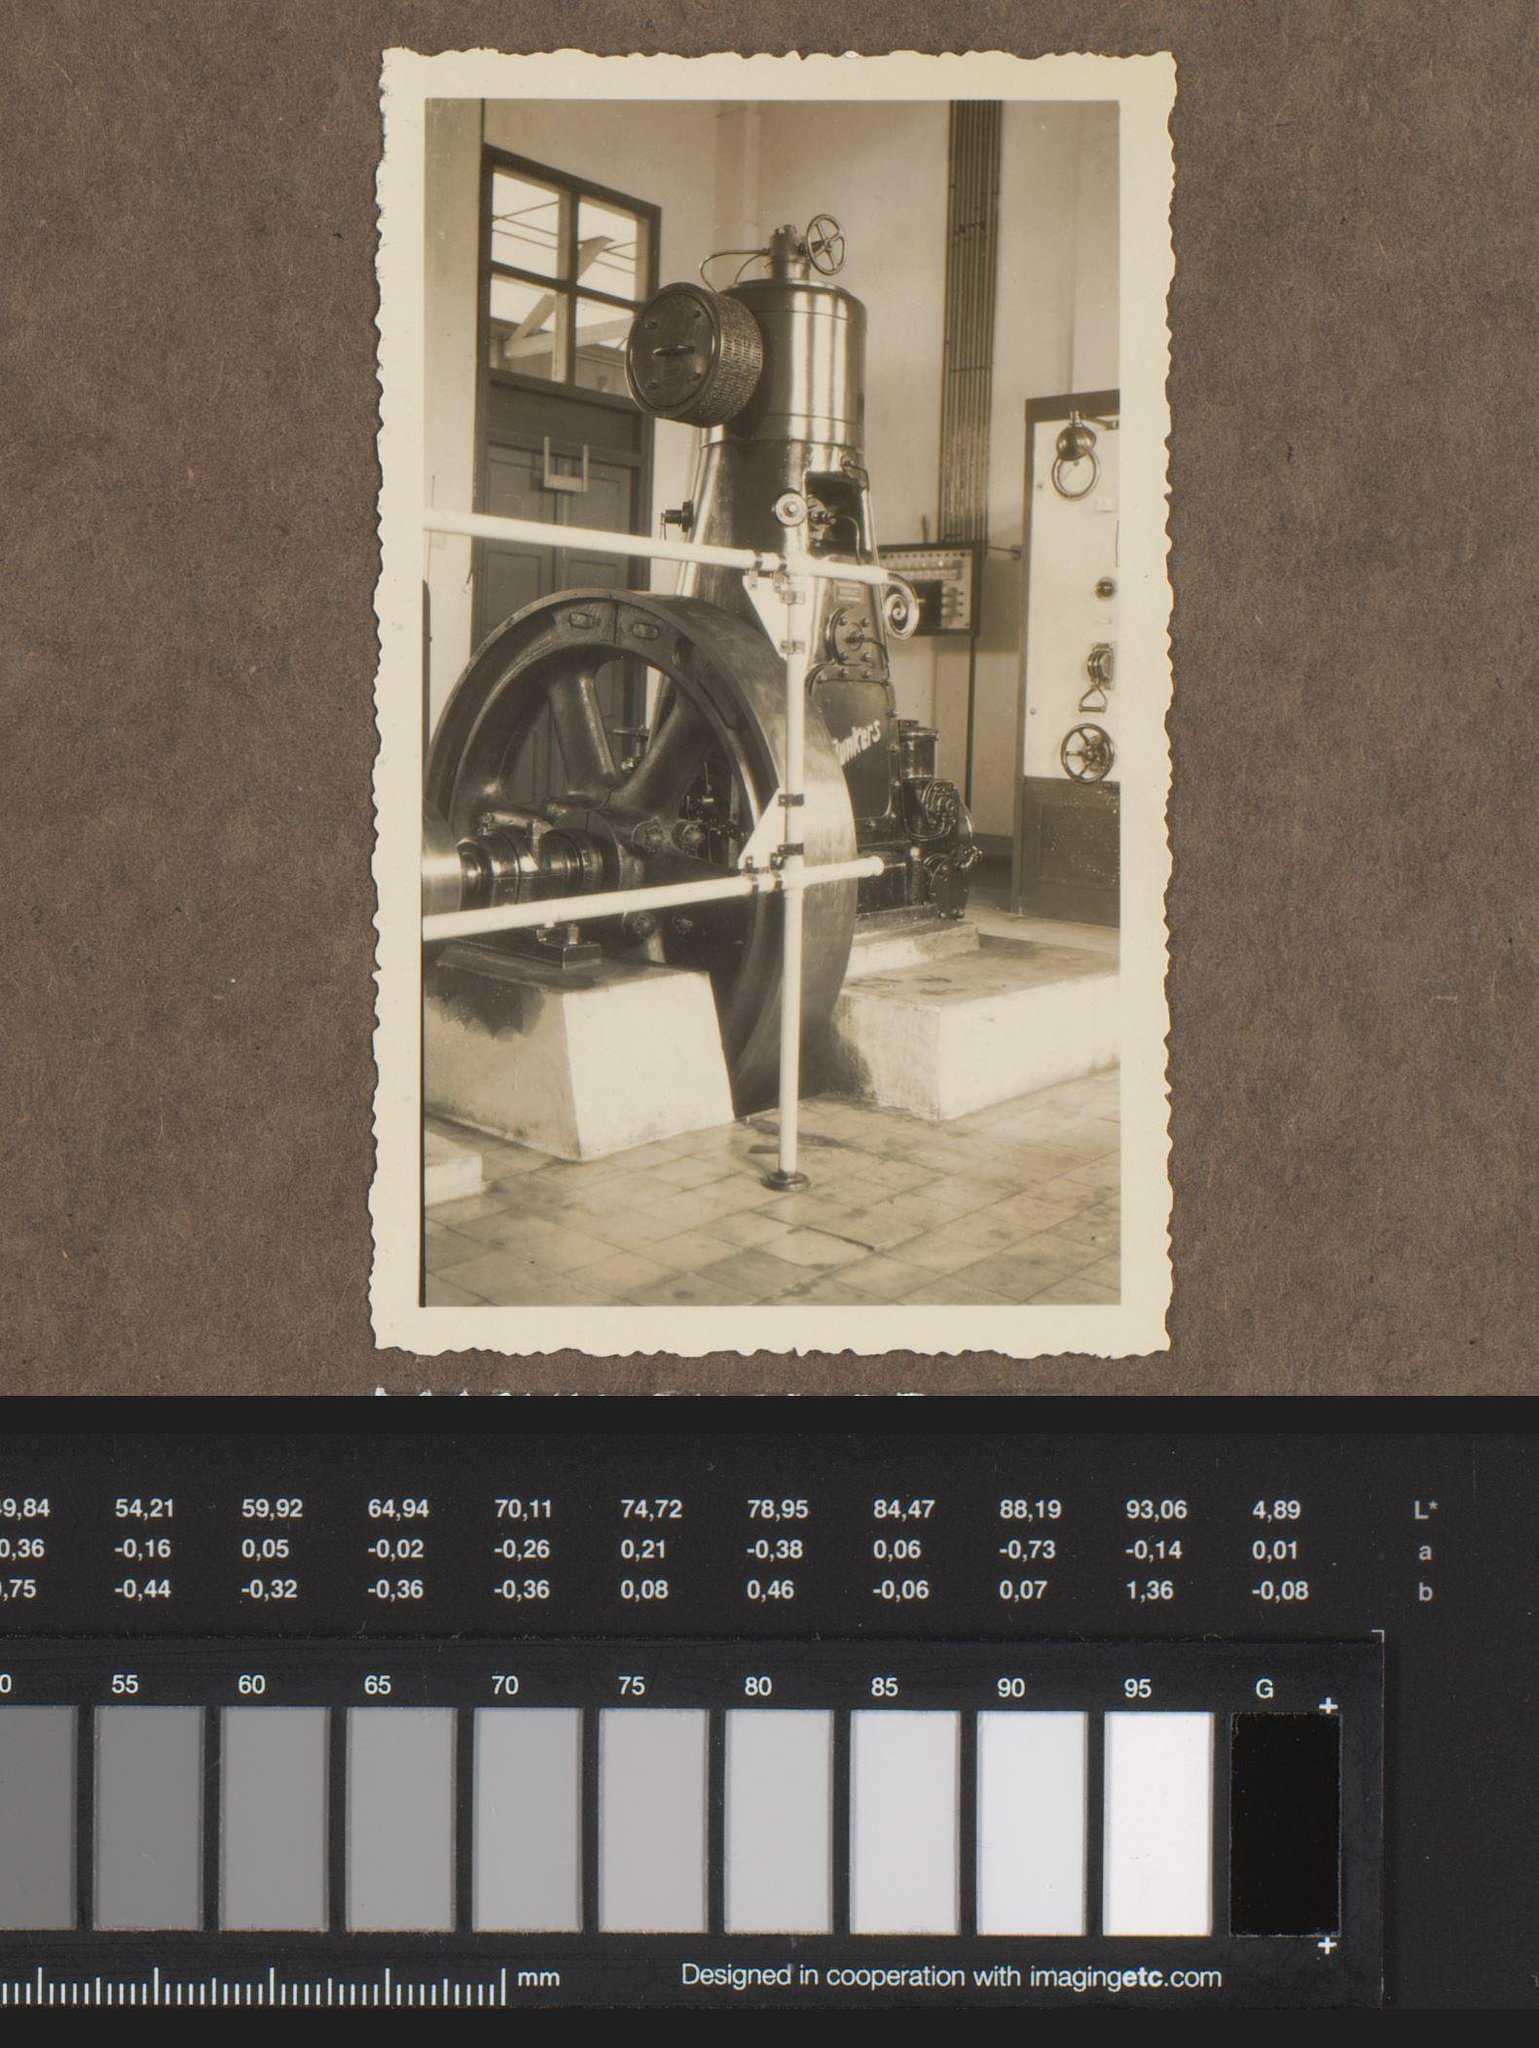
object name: photograph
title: Machinekamer van de Technische School te Bandoeng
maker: Anonymous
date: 1933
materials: photographic support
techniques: gelatin silver print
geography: bandung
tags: vocational education, e.g.: junior technical school, colonial government, dutch east indies, the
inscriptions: inscription: ‘Machinekamer / TS’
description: Gezicht in de machinekamer van de Technische School te Bandoeng. Foto ingeplakt in het fotoalbum aangeboden aan J.H.A. van der Hoeven bij het beëindigen op 31 juli 1933 van zijn diensttijd bij het Nijverheidsonderwijs in Nederlandsch-Indië.